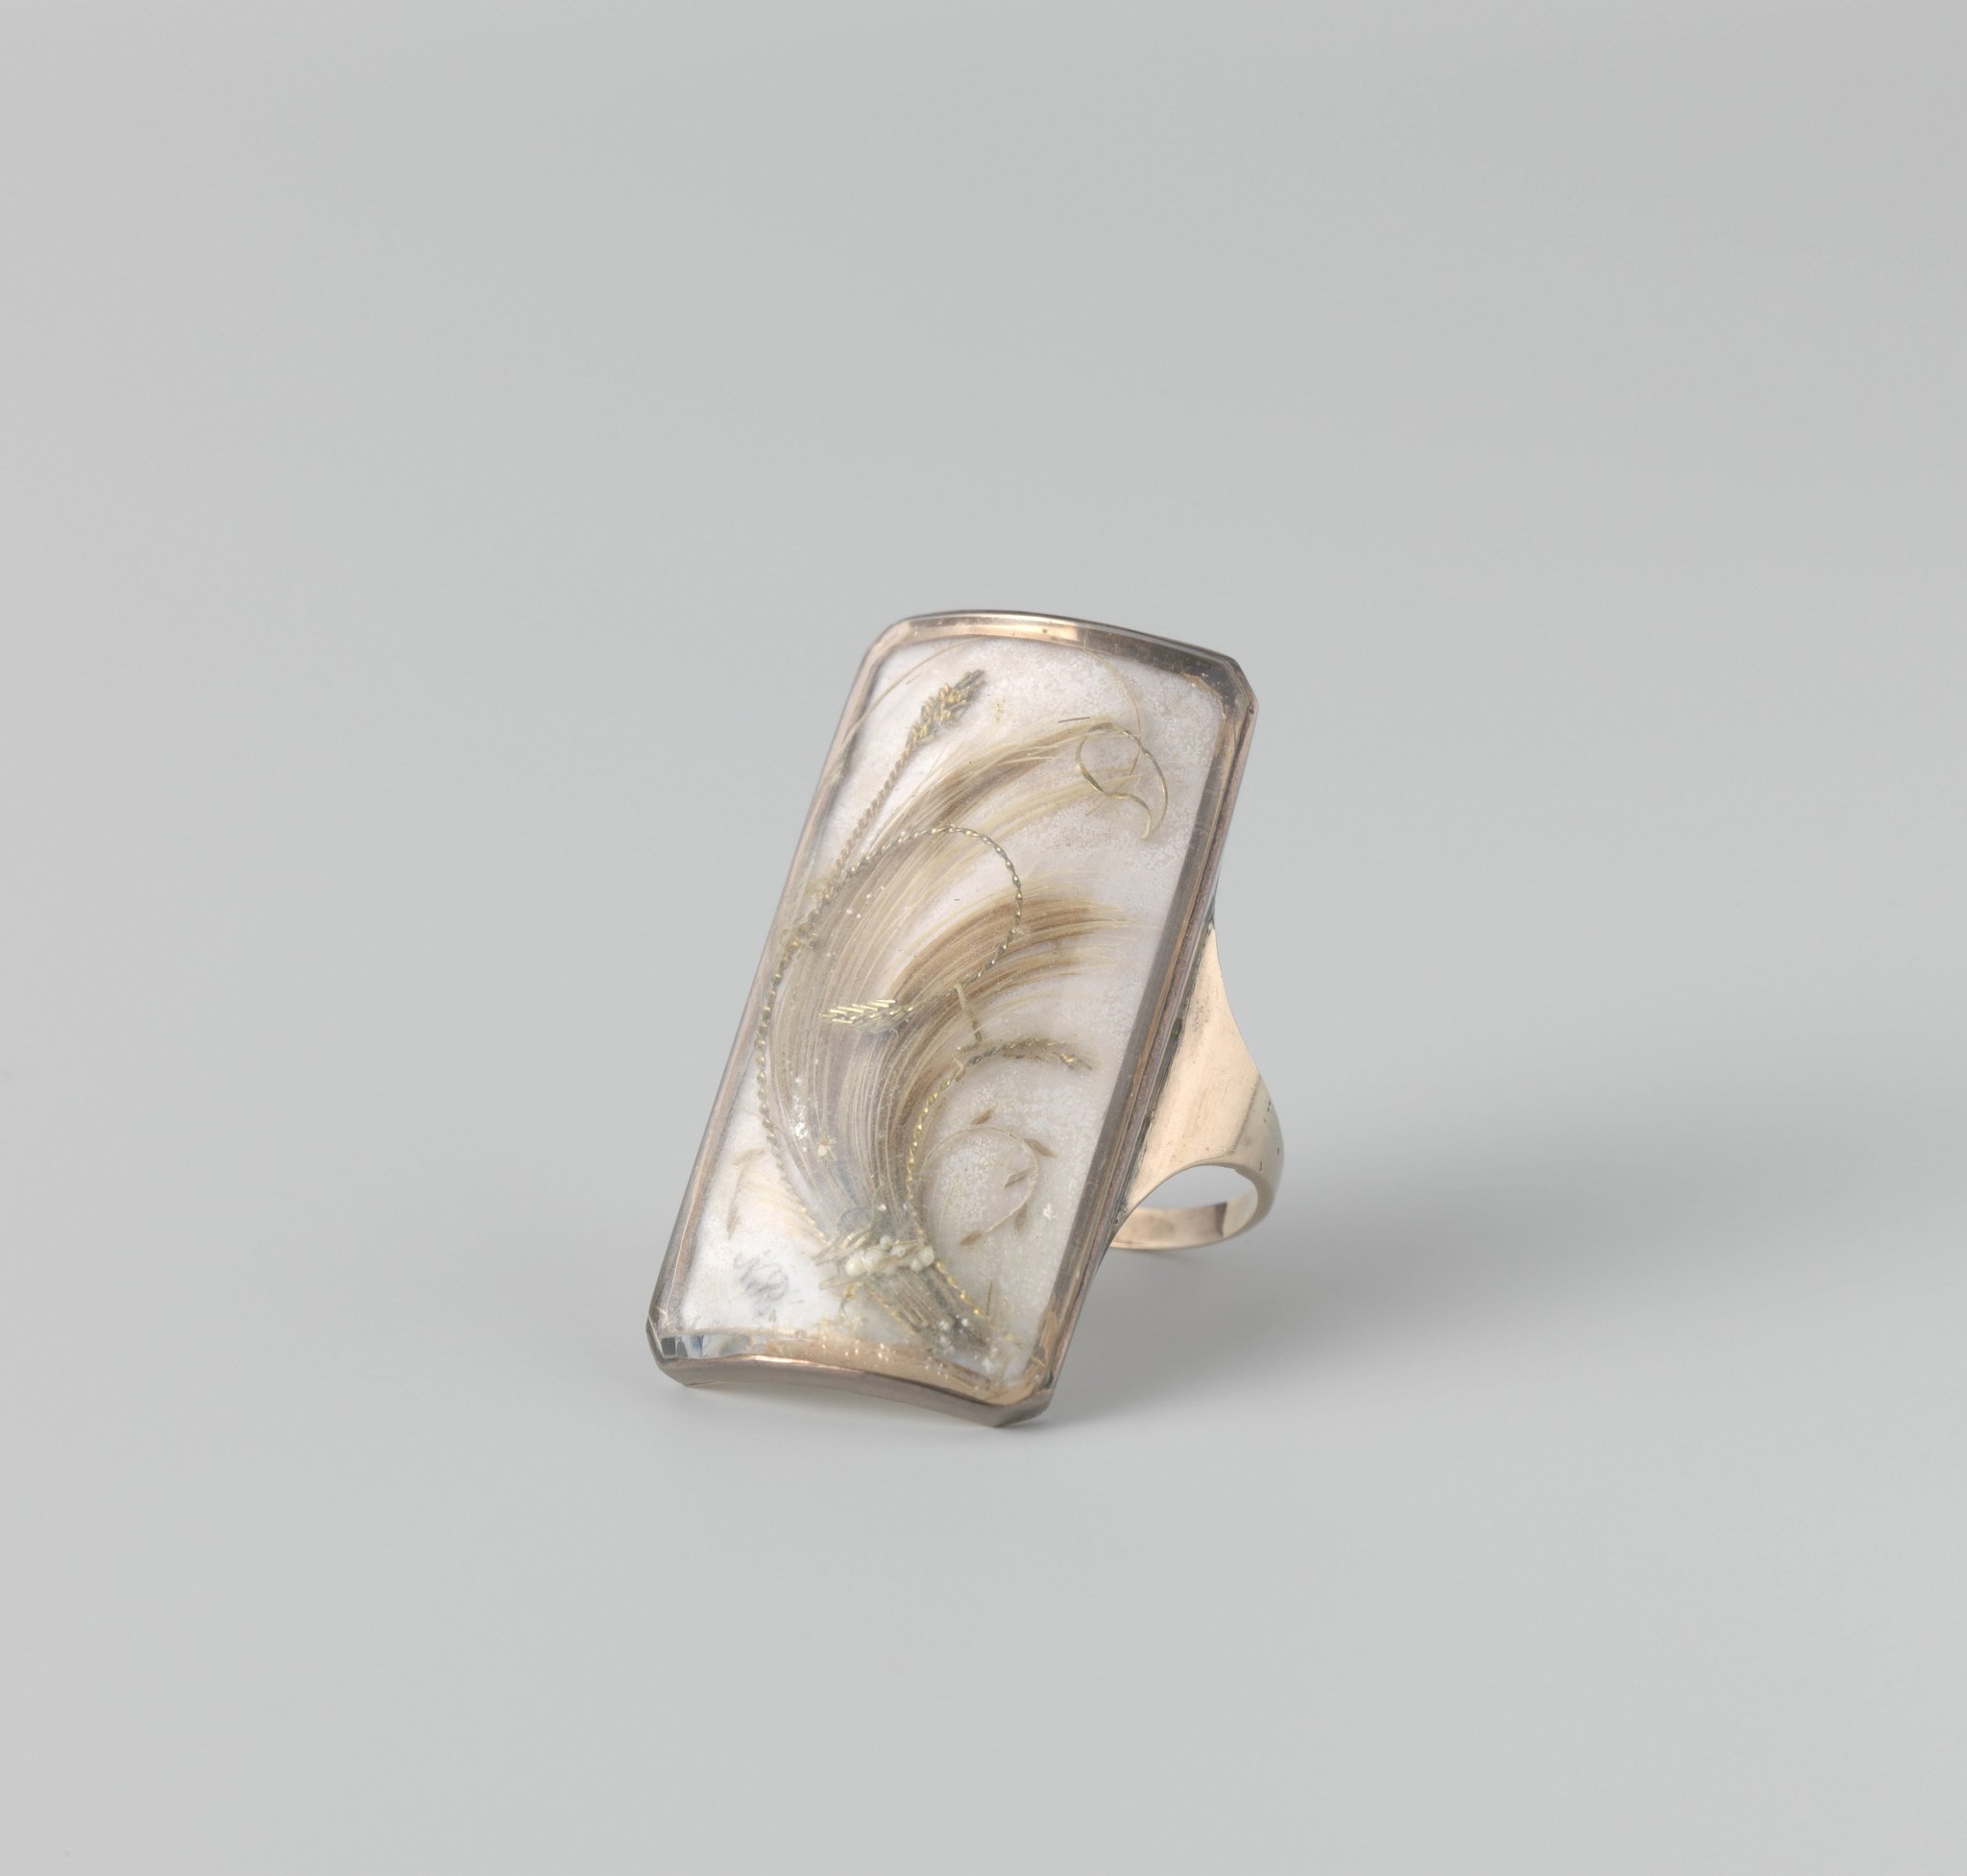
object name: jewellery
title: Verlovingsring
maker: Anonymous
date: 1825-1850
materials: crystal, gold, hair, ivory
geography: netherlands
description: Verlovingsring van goud. Bovenop een langwerpig plaatje kristal, waaronder een haarlok met gouddraad versierd, op een rode achtergrond. Getekend met de letters N.B.